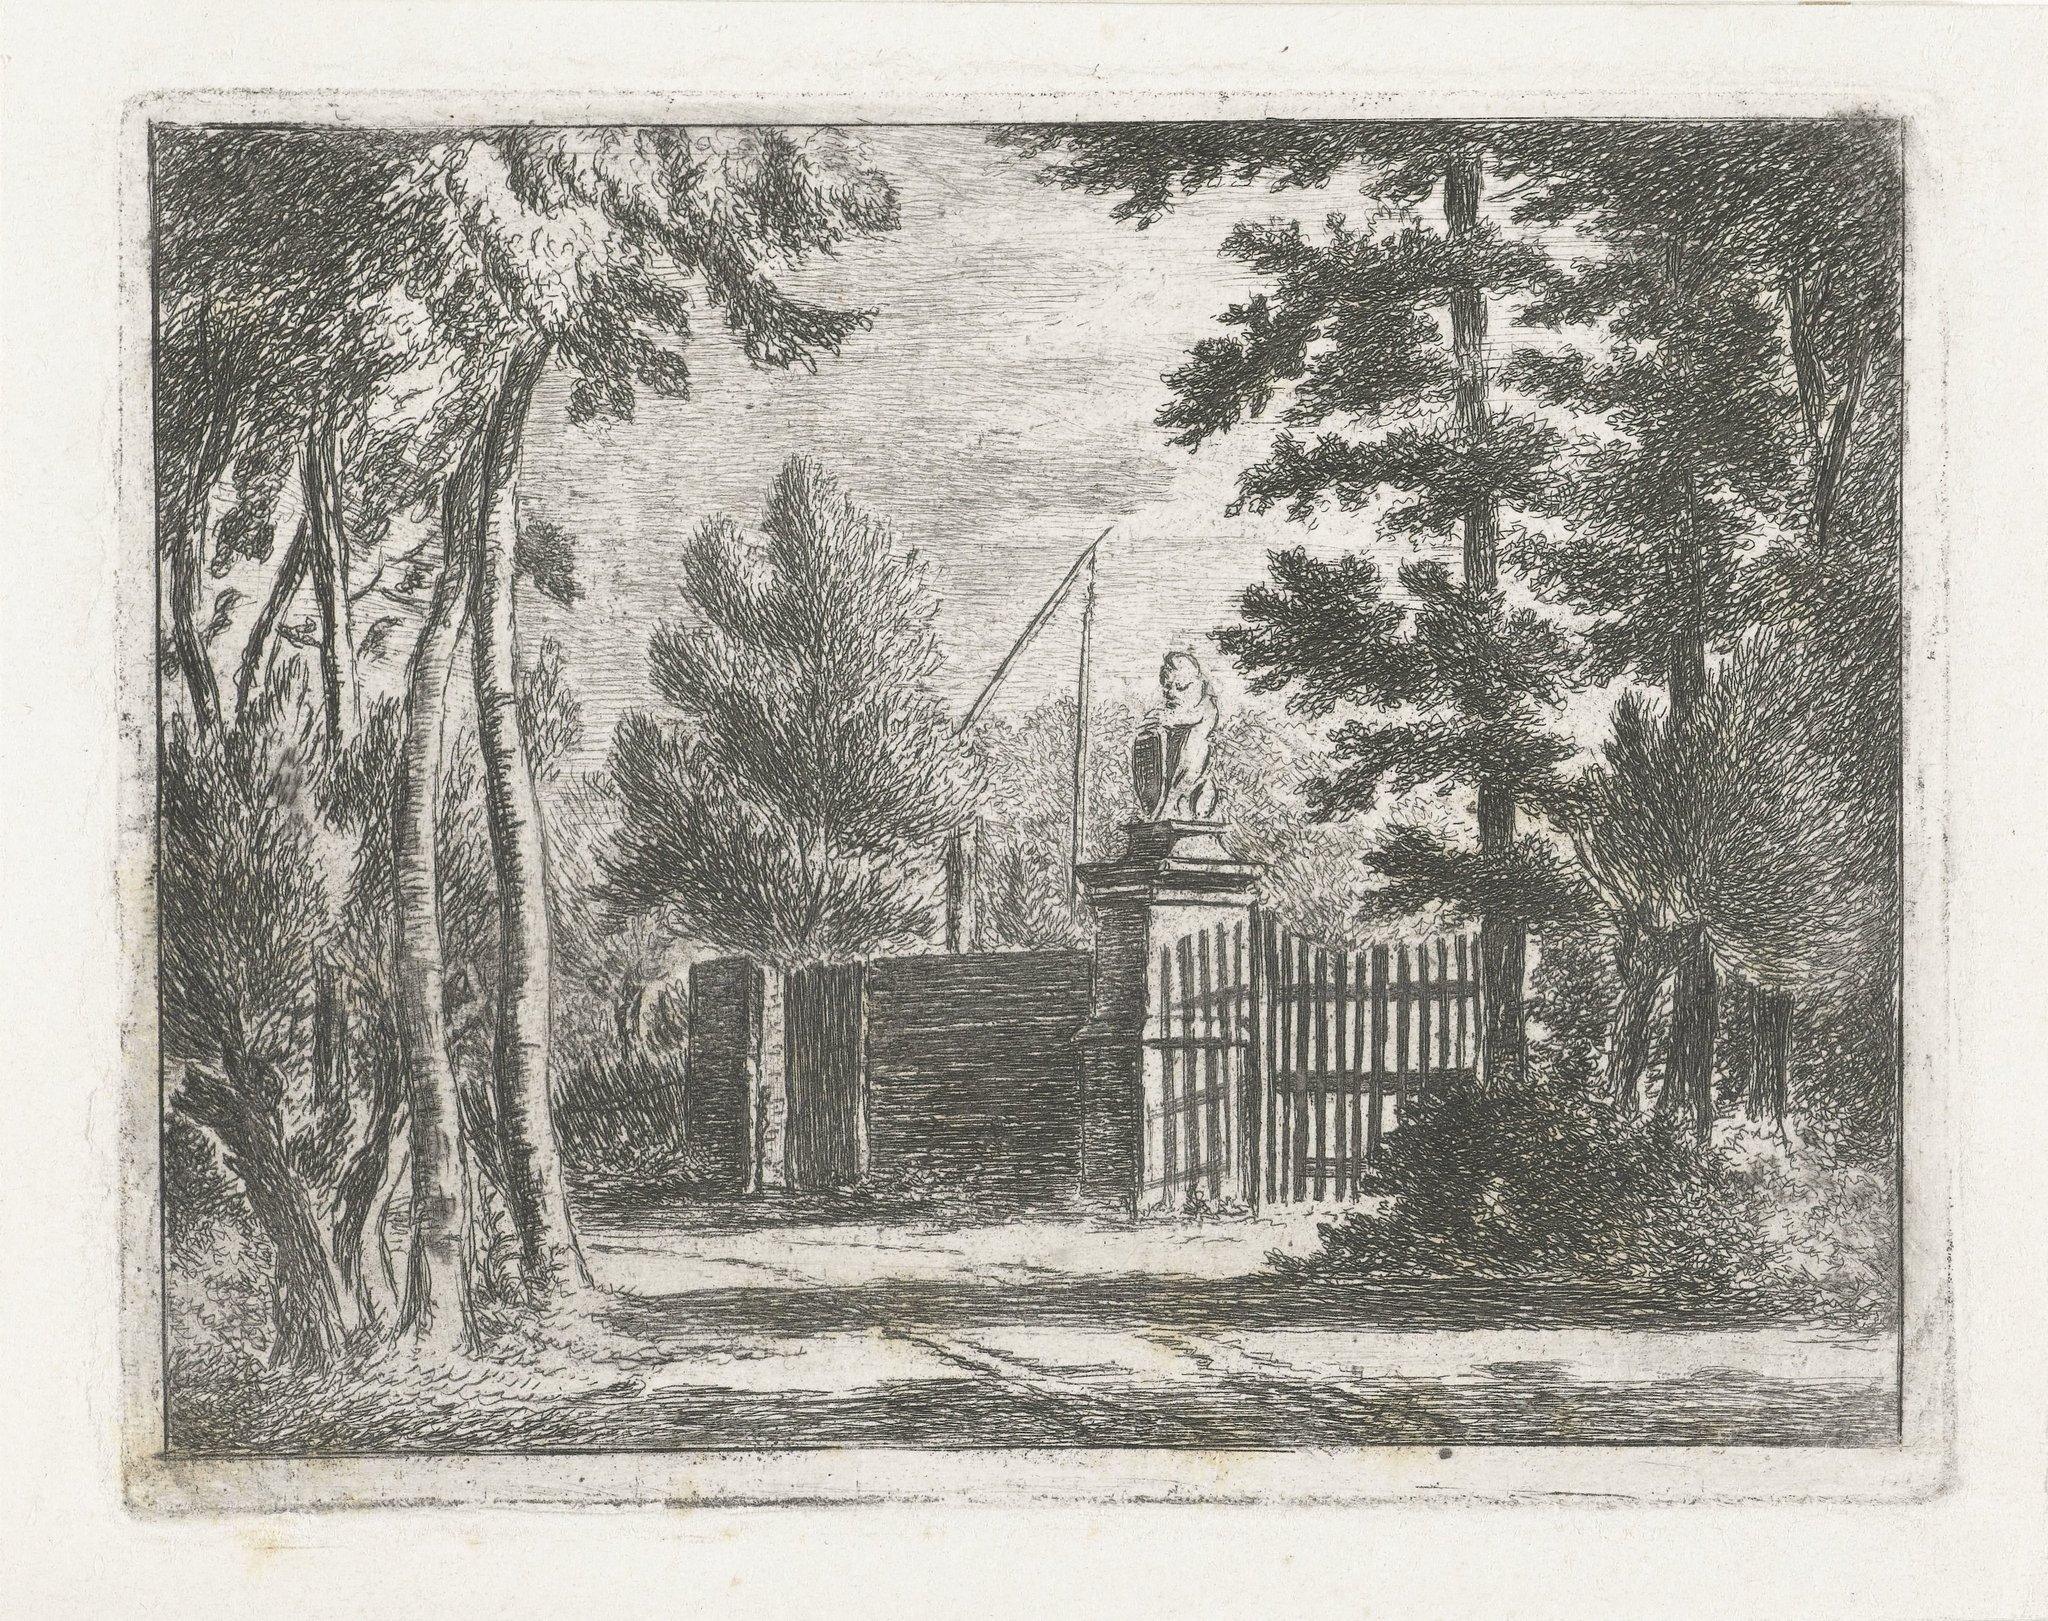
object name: print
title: Poort van een buitenplaats met leeuwenbeeld op een kolom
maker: jacobus cornelis gaal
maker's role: print maker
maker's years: 1796-1866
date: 1854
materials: paper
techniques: etching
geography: netherlands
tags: gate, entrance, village lane, alley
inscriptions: collector's mark: Lugt 2228